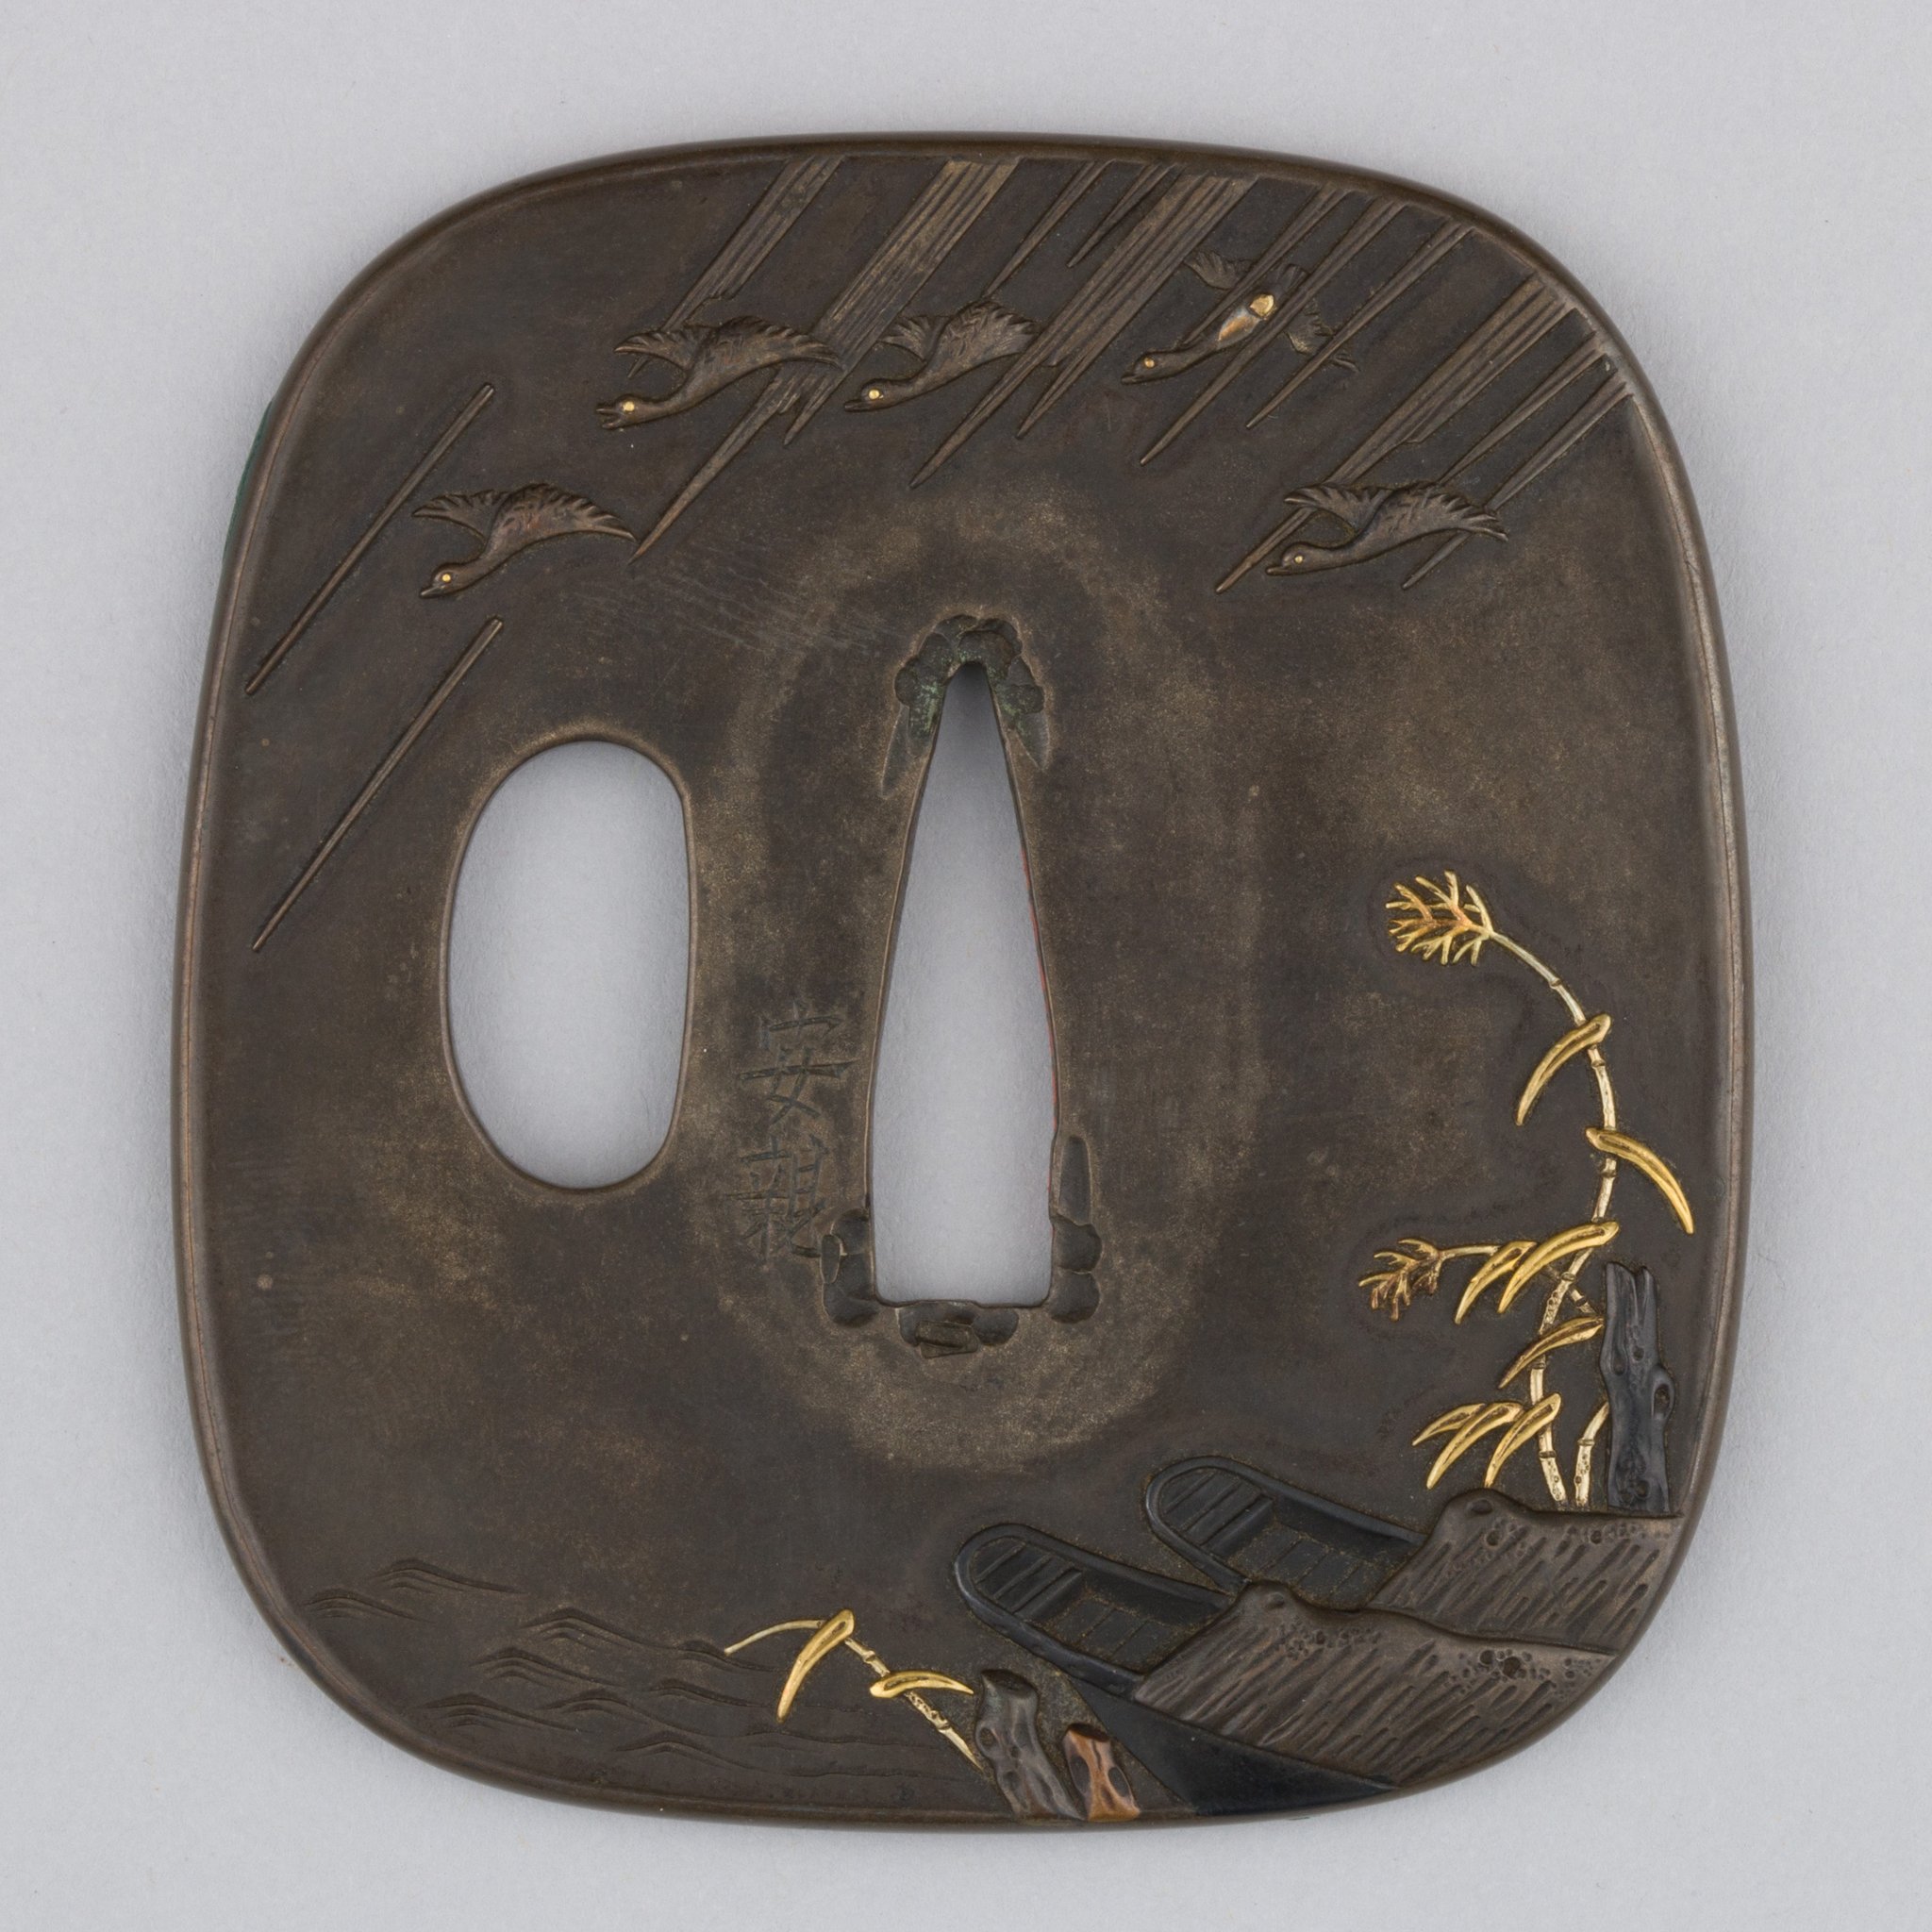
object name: sword guard tsuba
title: Sword Guard (Tsuba)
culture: japanese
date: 1615-1868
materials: copper, gold alloy, silver alloy, gold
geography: japan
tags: birds,boats